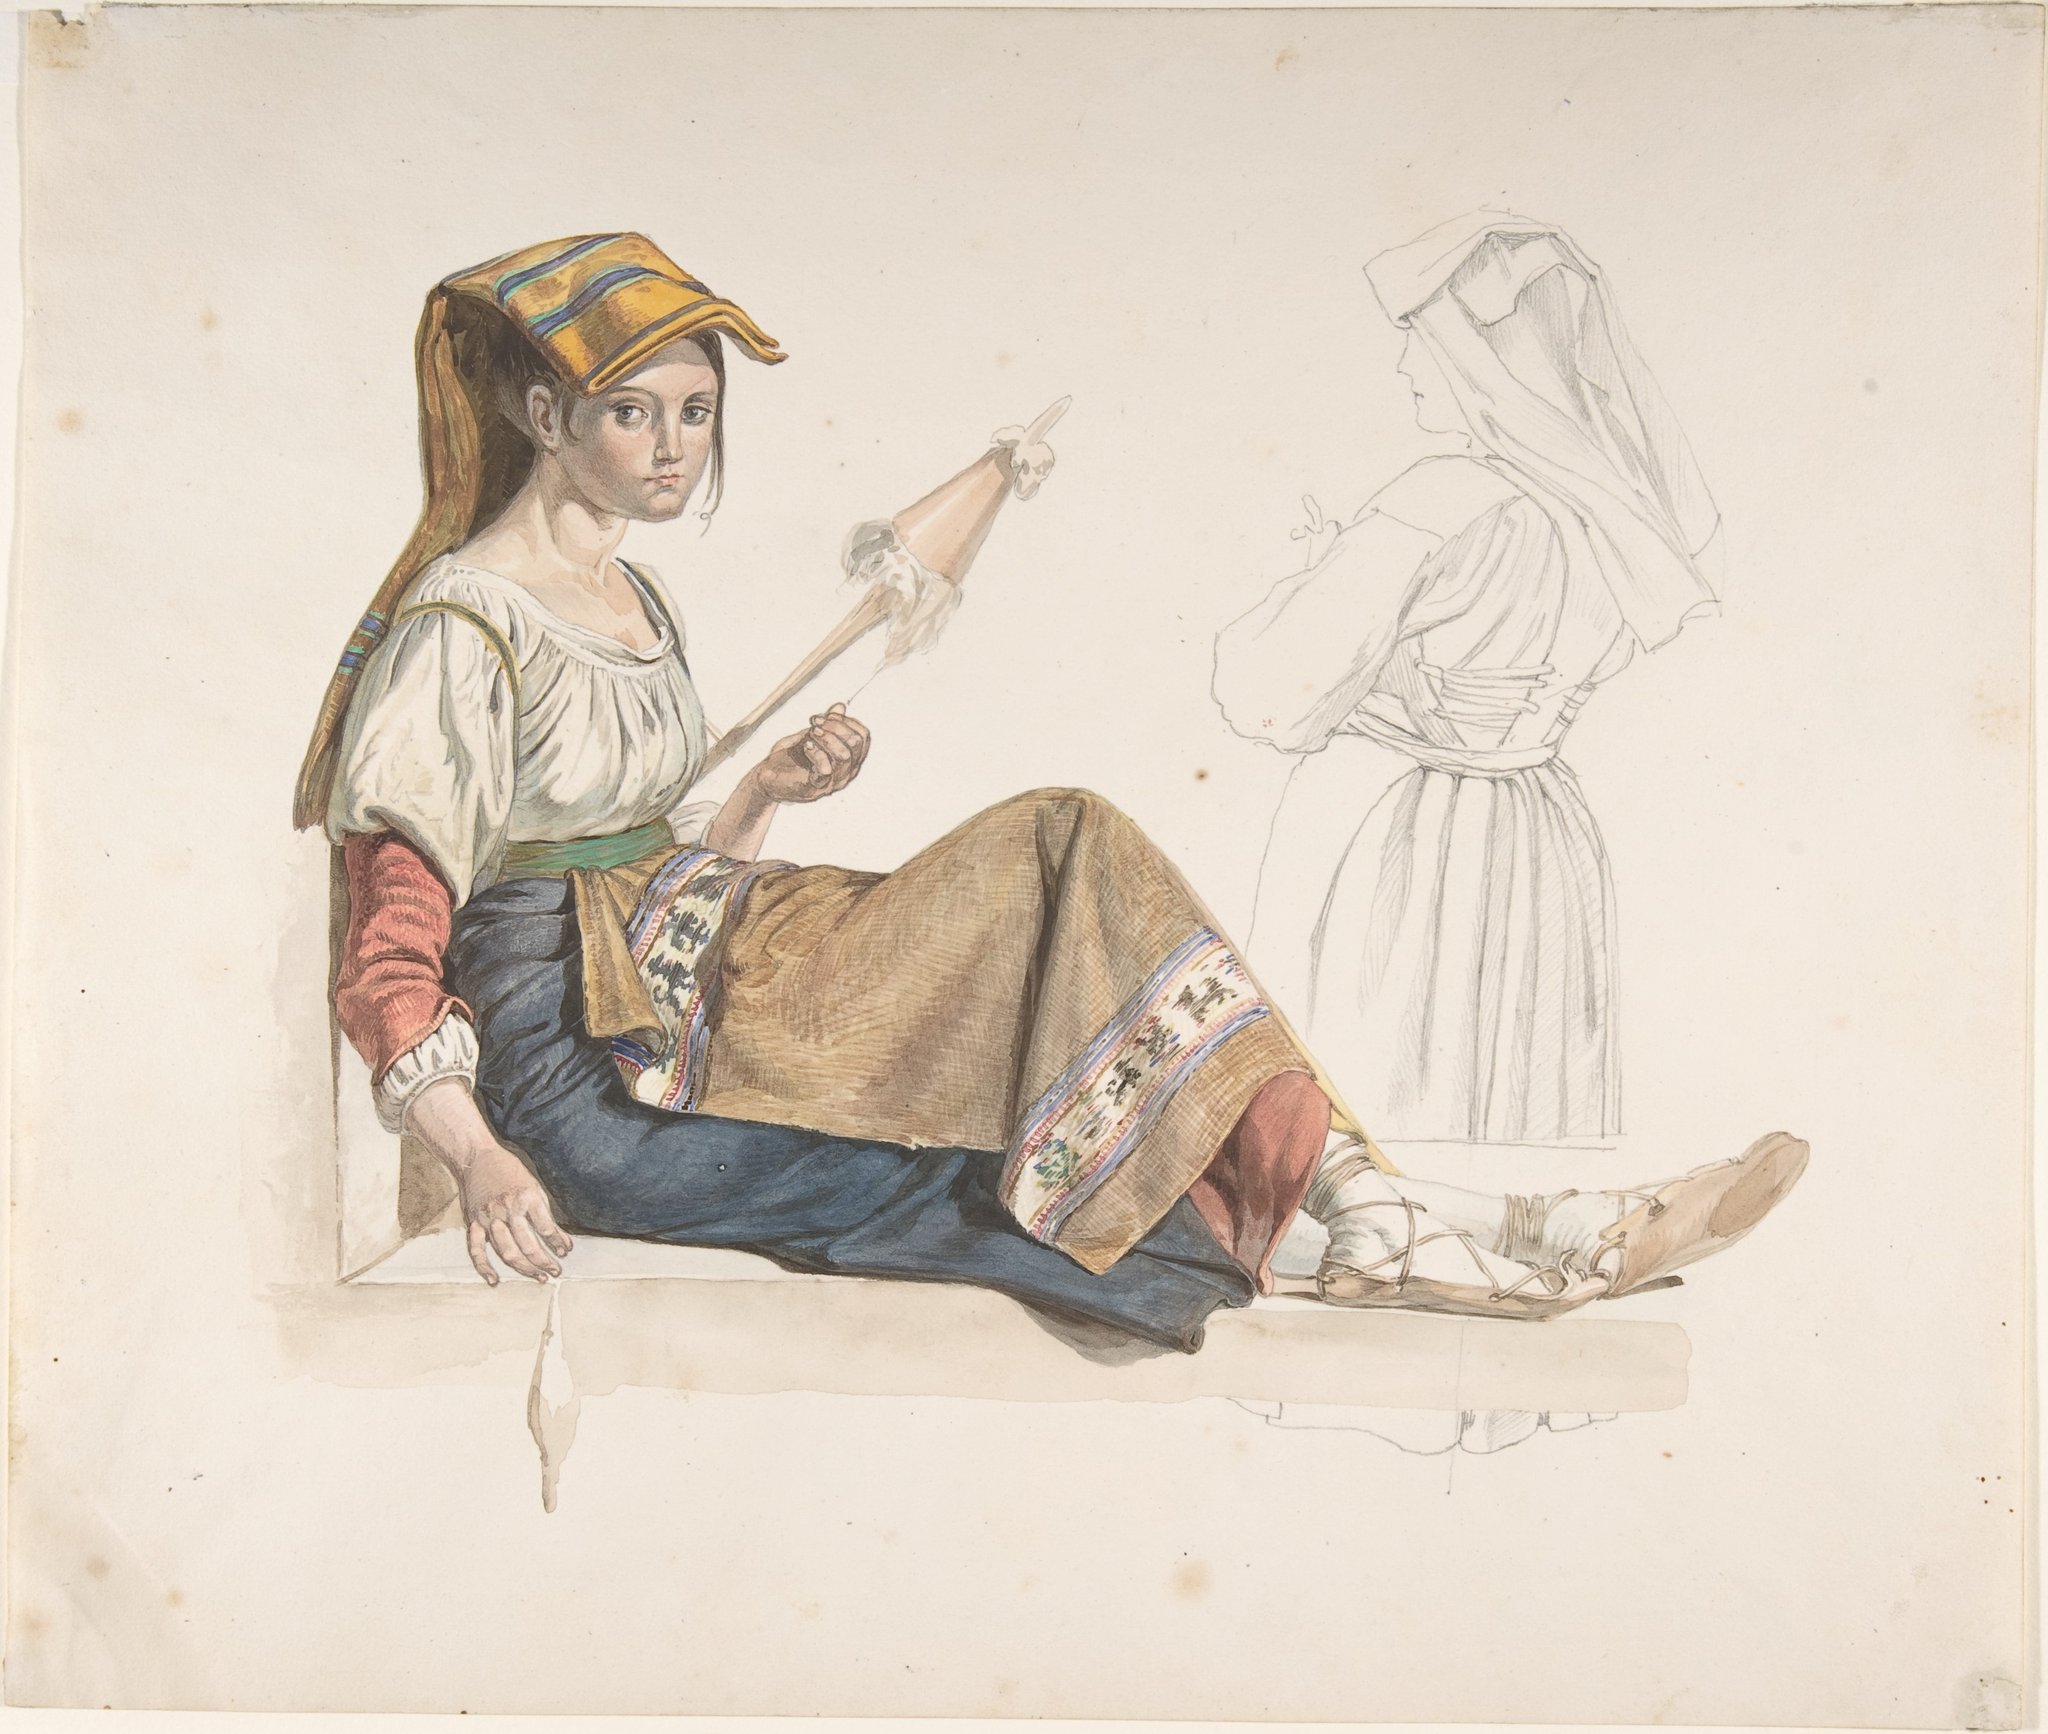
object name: drawing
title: Neapolitan Woman (recto); Study for an Interior (verso)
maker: karl wilhelm freiherr von heideck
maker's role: artist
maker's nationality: german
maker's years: 1788-1861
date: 1767-1900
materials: graphite, watercolor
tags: women